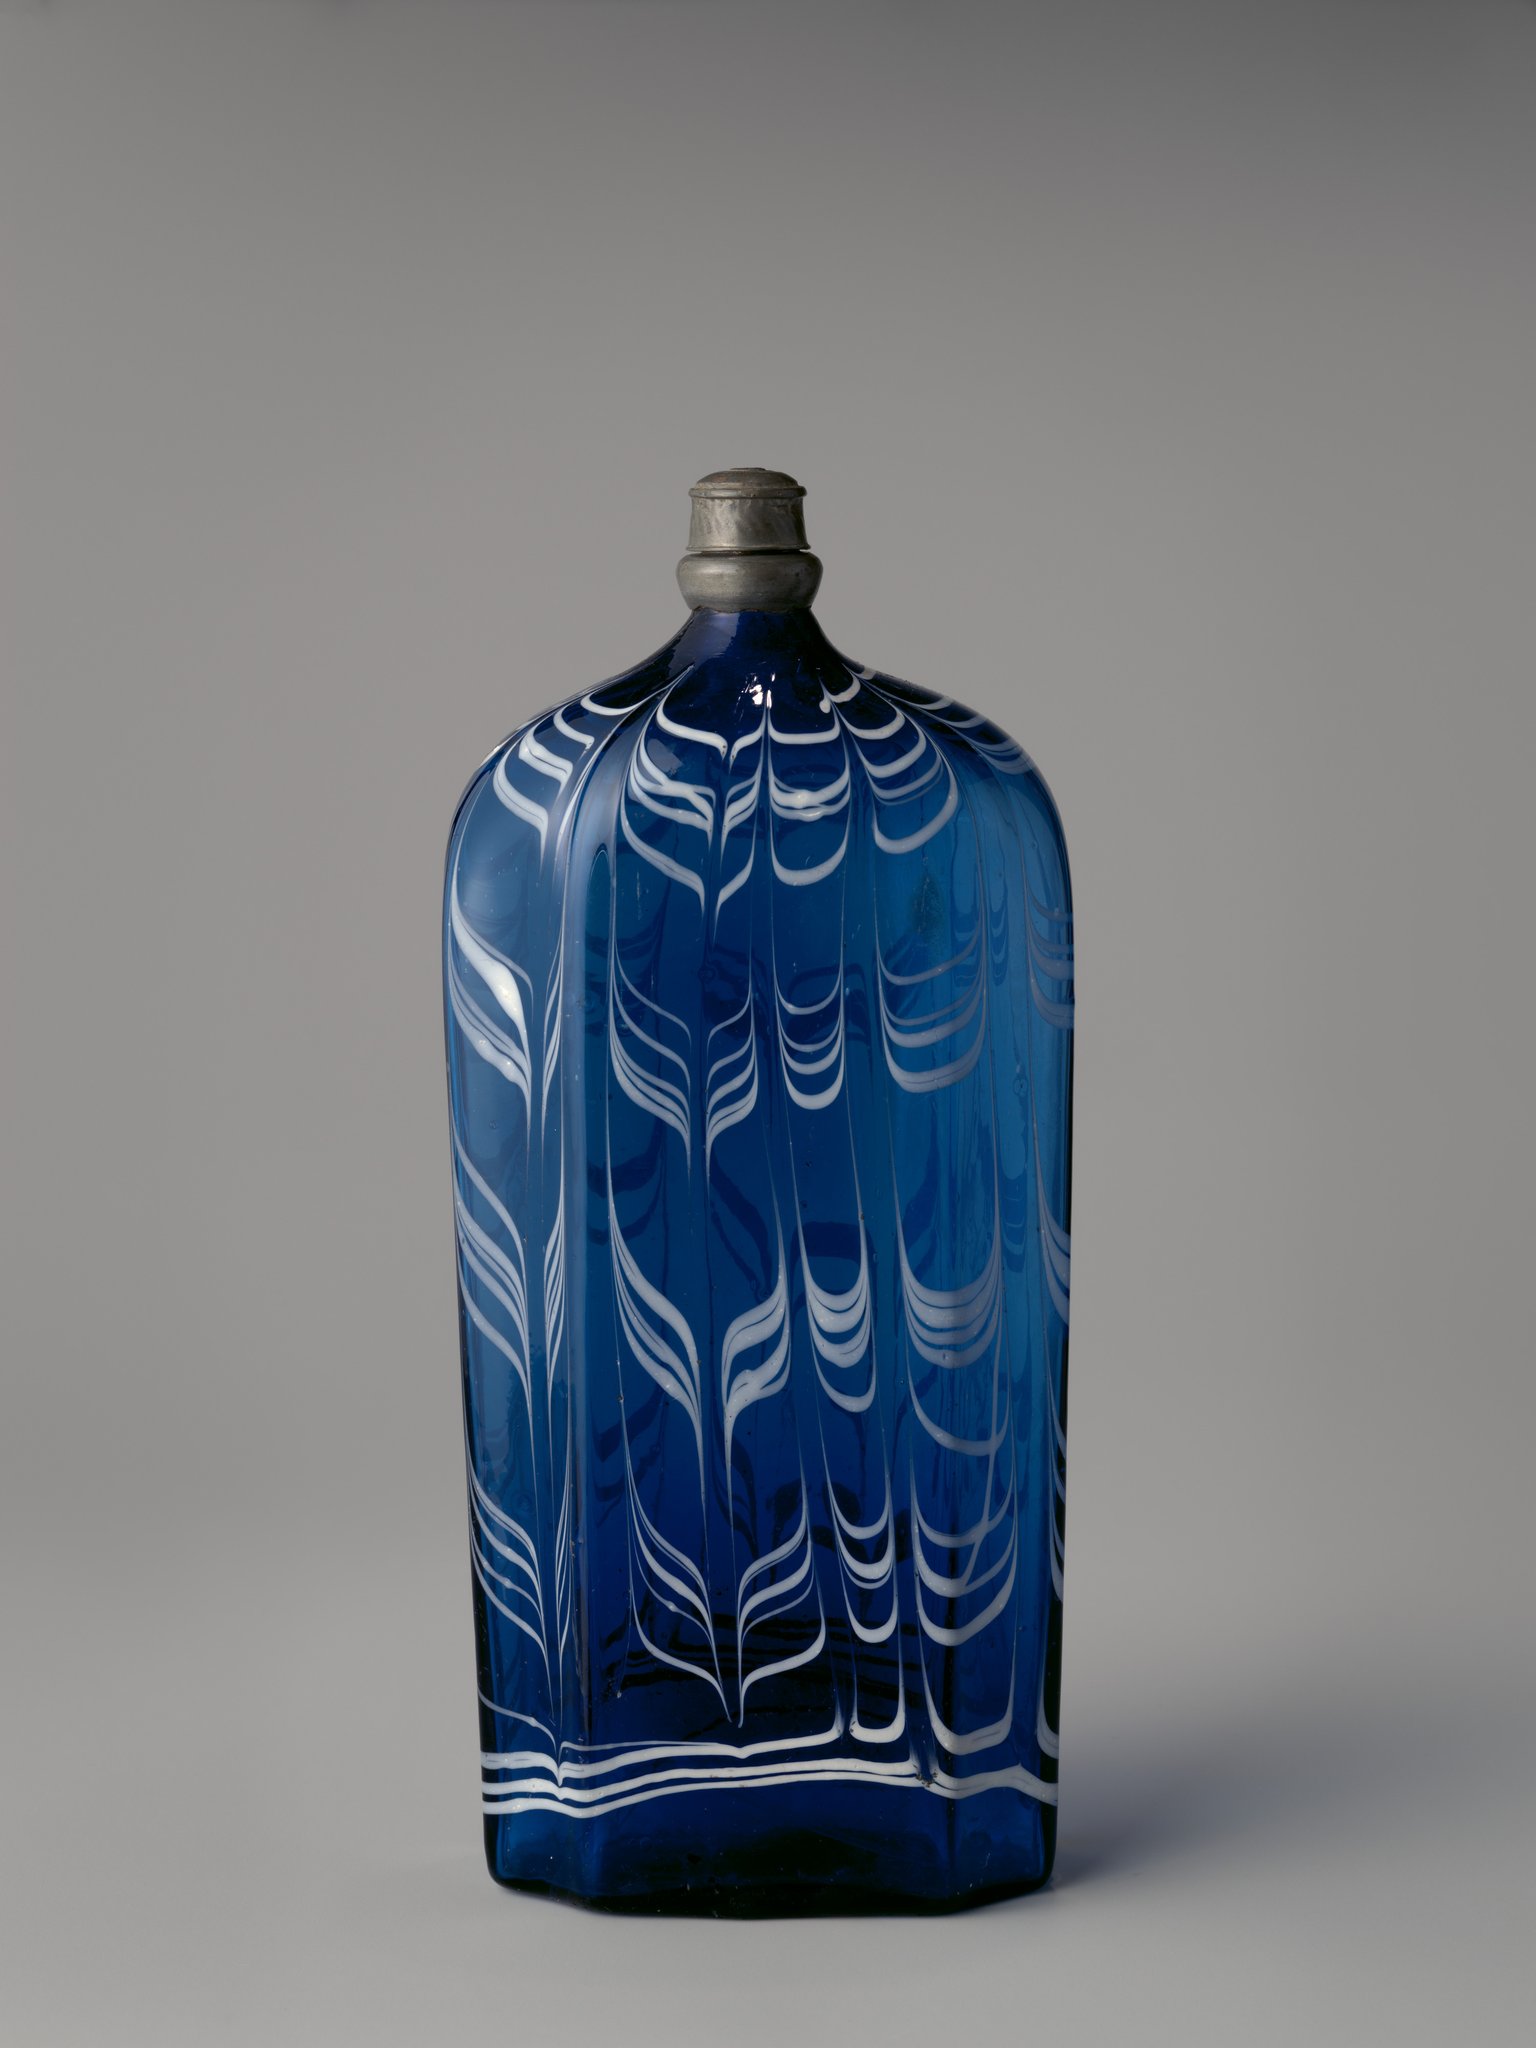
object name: bottle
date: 1701-1800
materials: glass, pewter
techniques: glassblowing